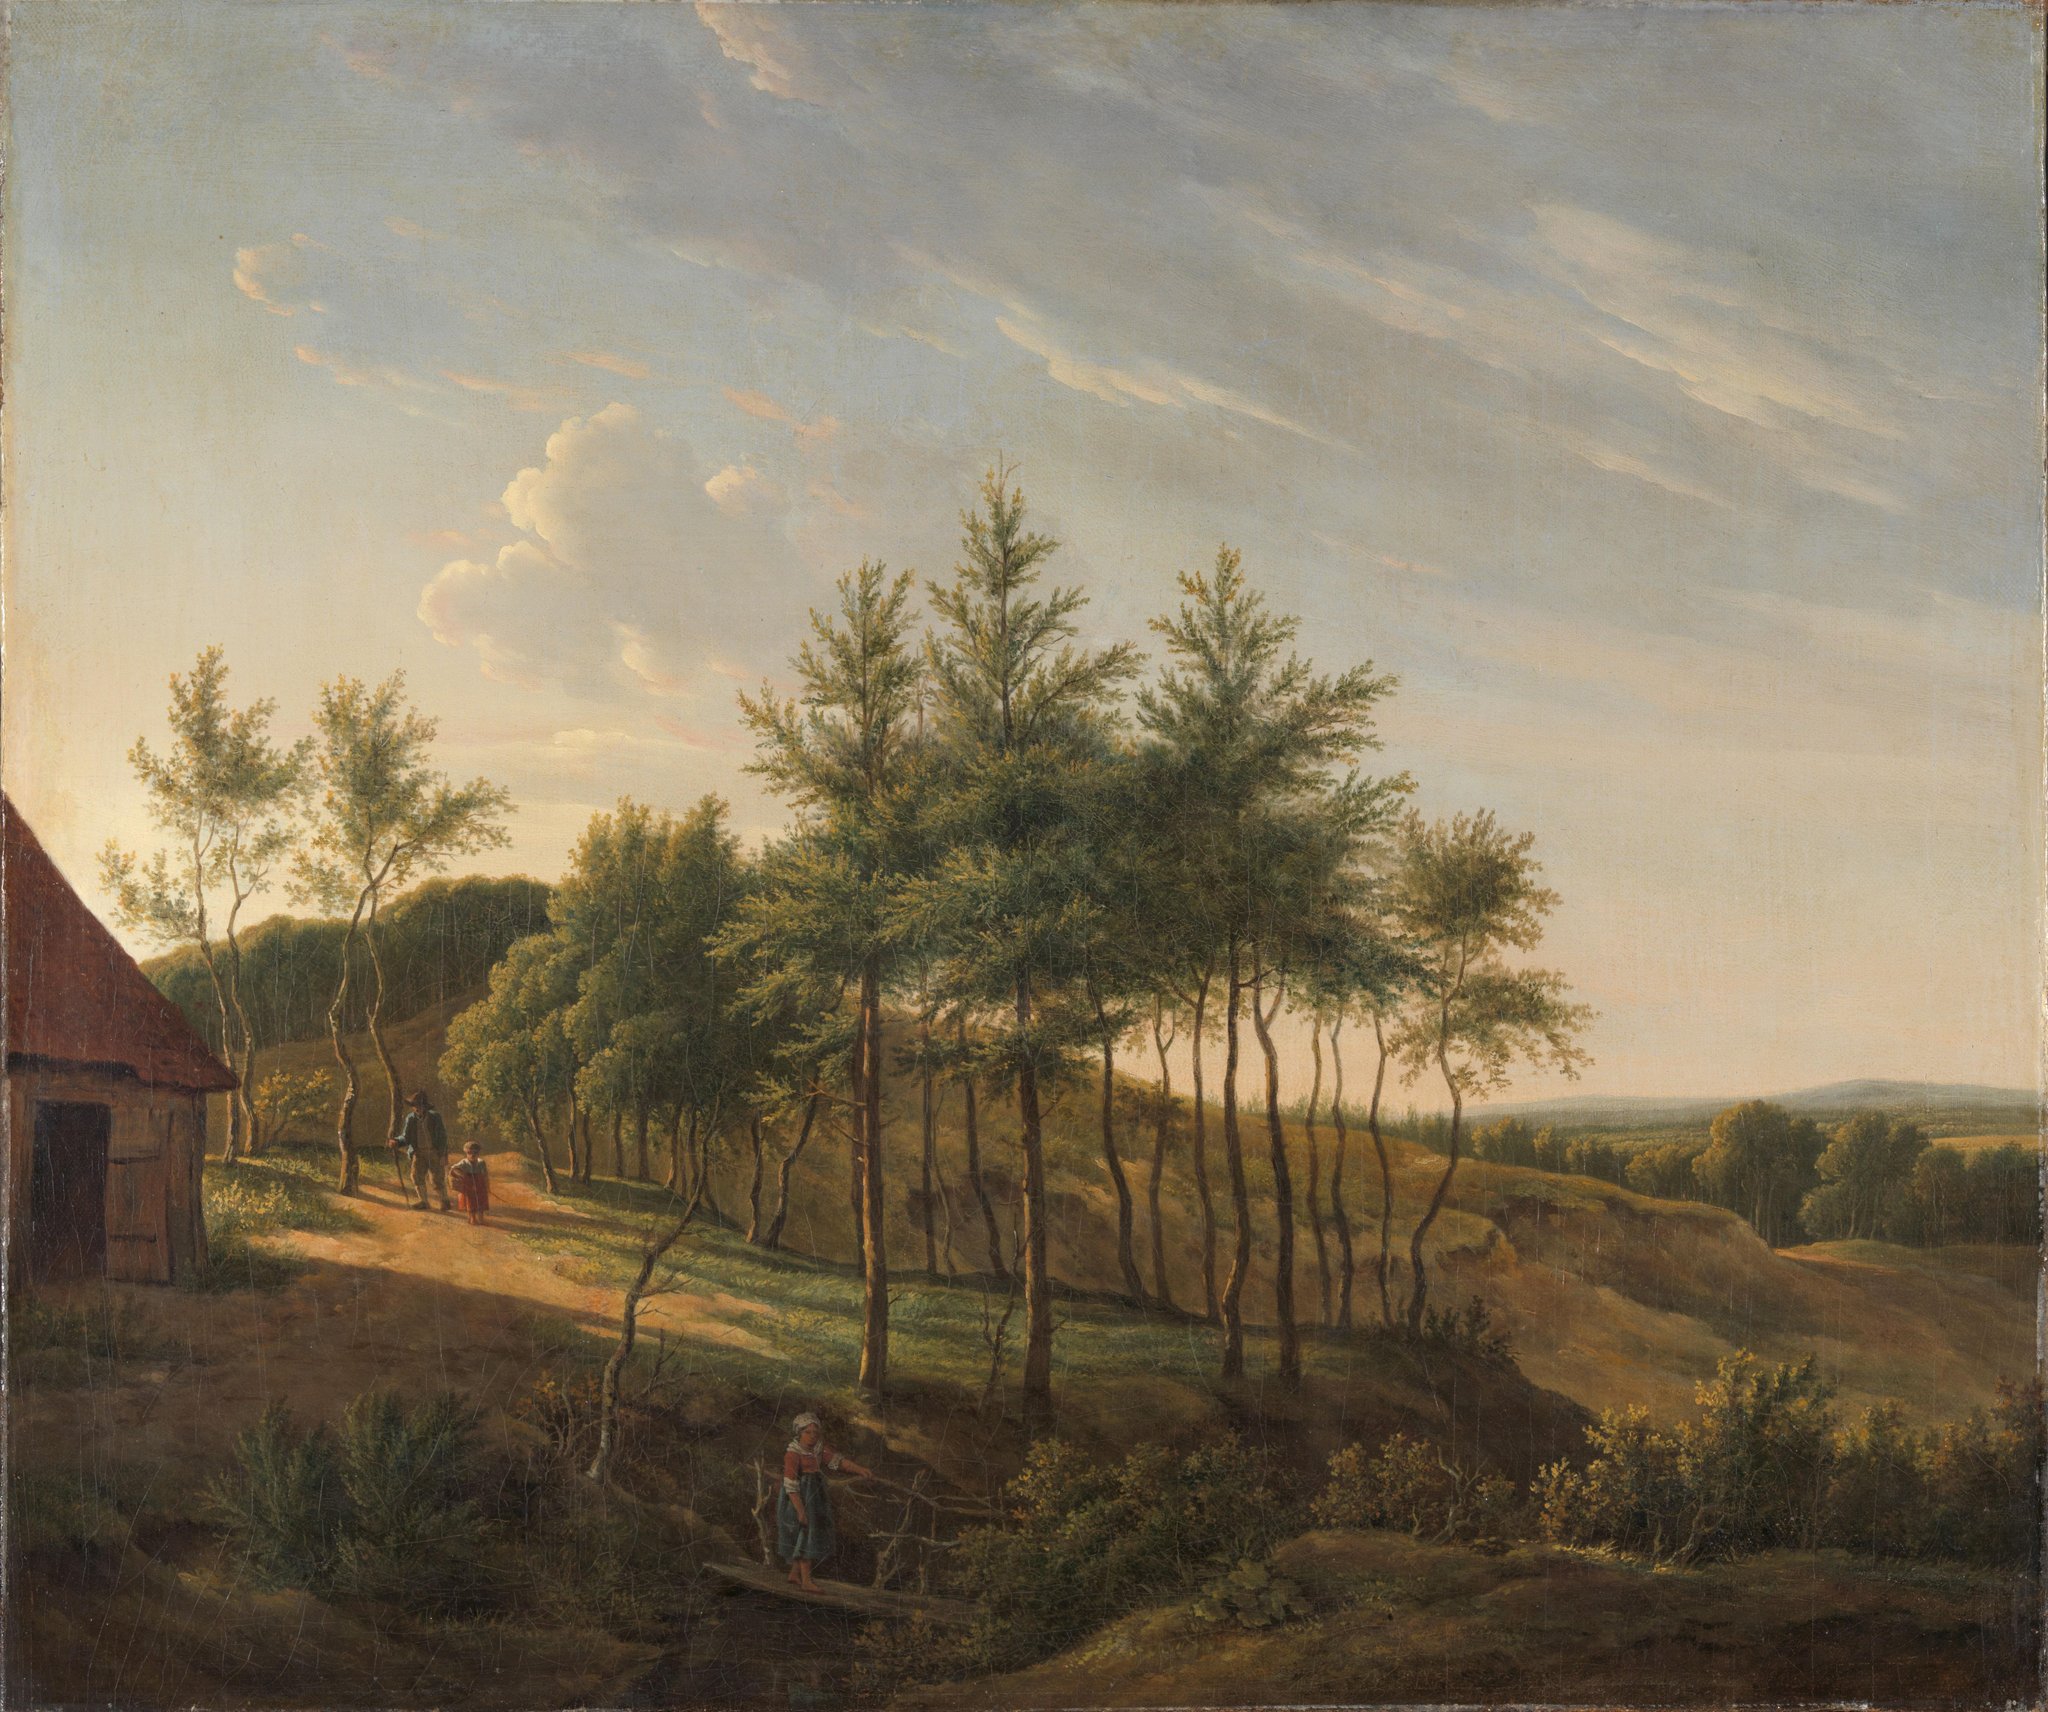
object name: painting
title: Hilly Landscape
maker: gerrit jan michaëlis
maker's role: draughtsman, painter, print maker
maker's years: 1775-1857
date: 1814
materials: canvas, oil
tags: low hill country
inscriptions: signature and date: ‘G.J.M. 1814’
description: Heuvelachtig landschap. Een landweg loopt over een heuveltop langs een boerenschuur. Op de voorgrond een vrouw op een houten bruggetje.